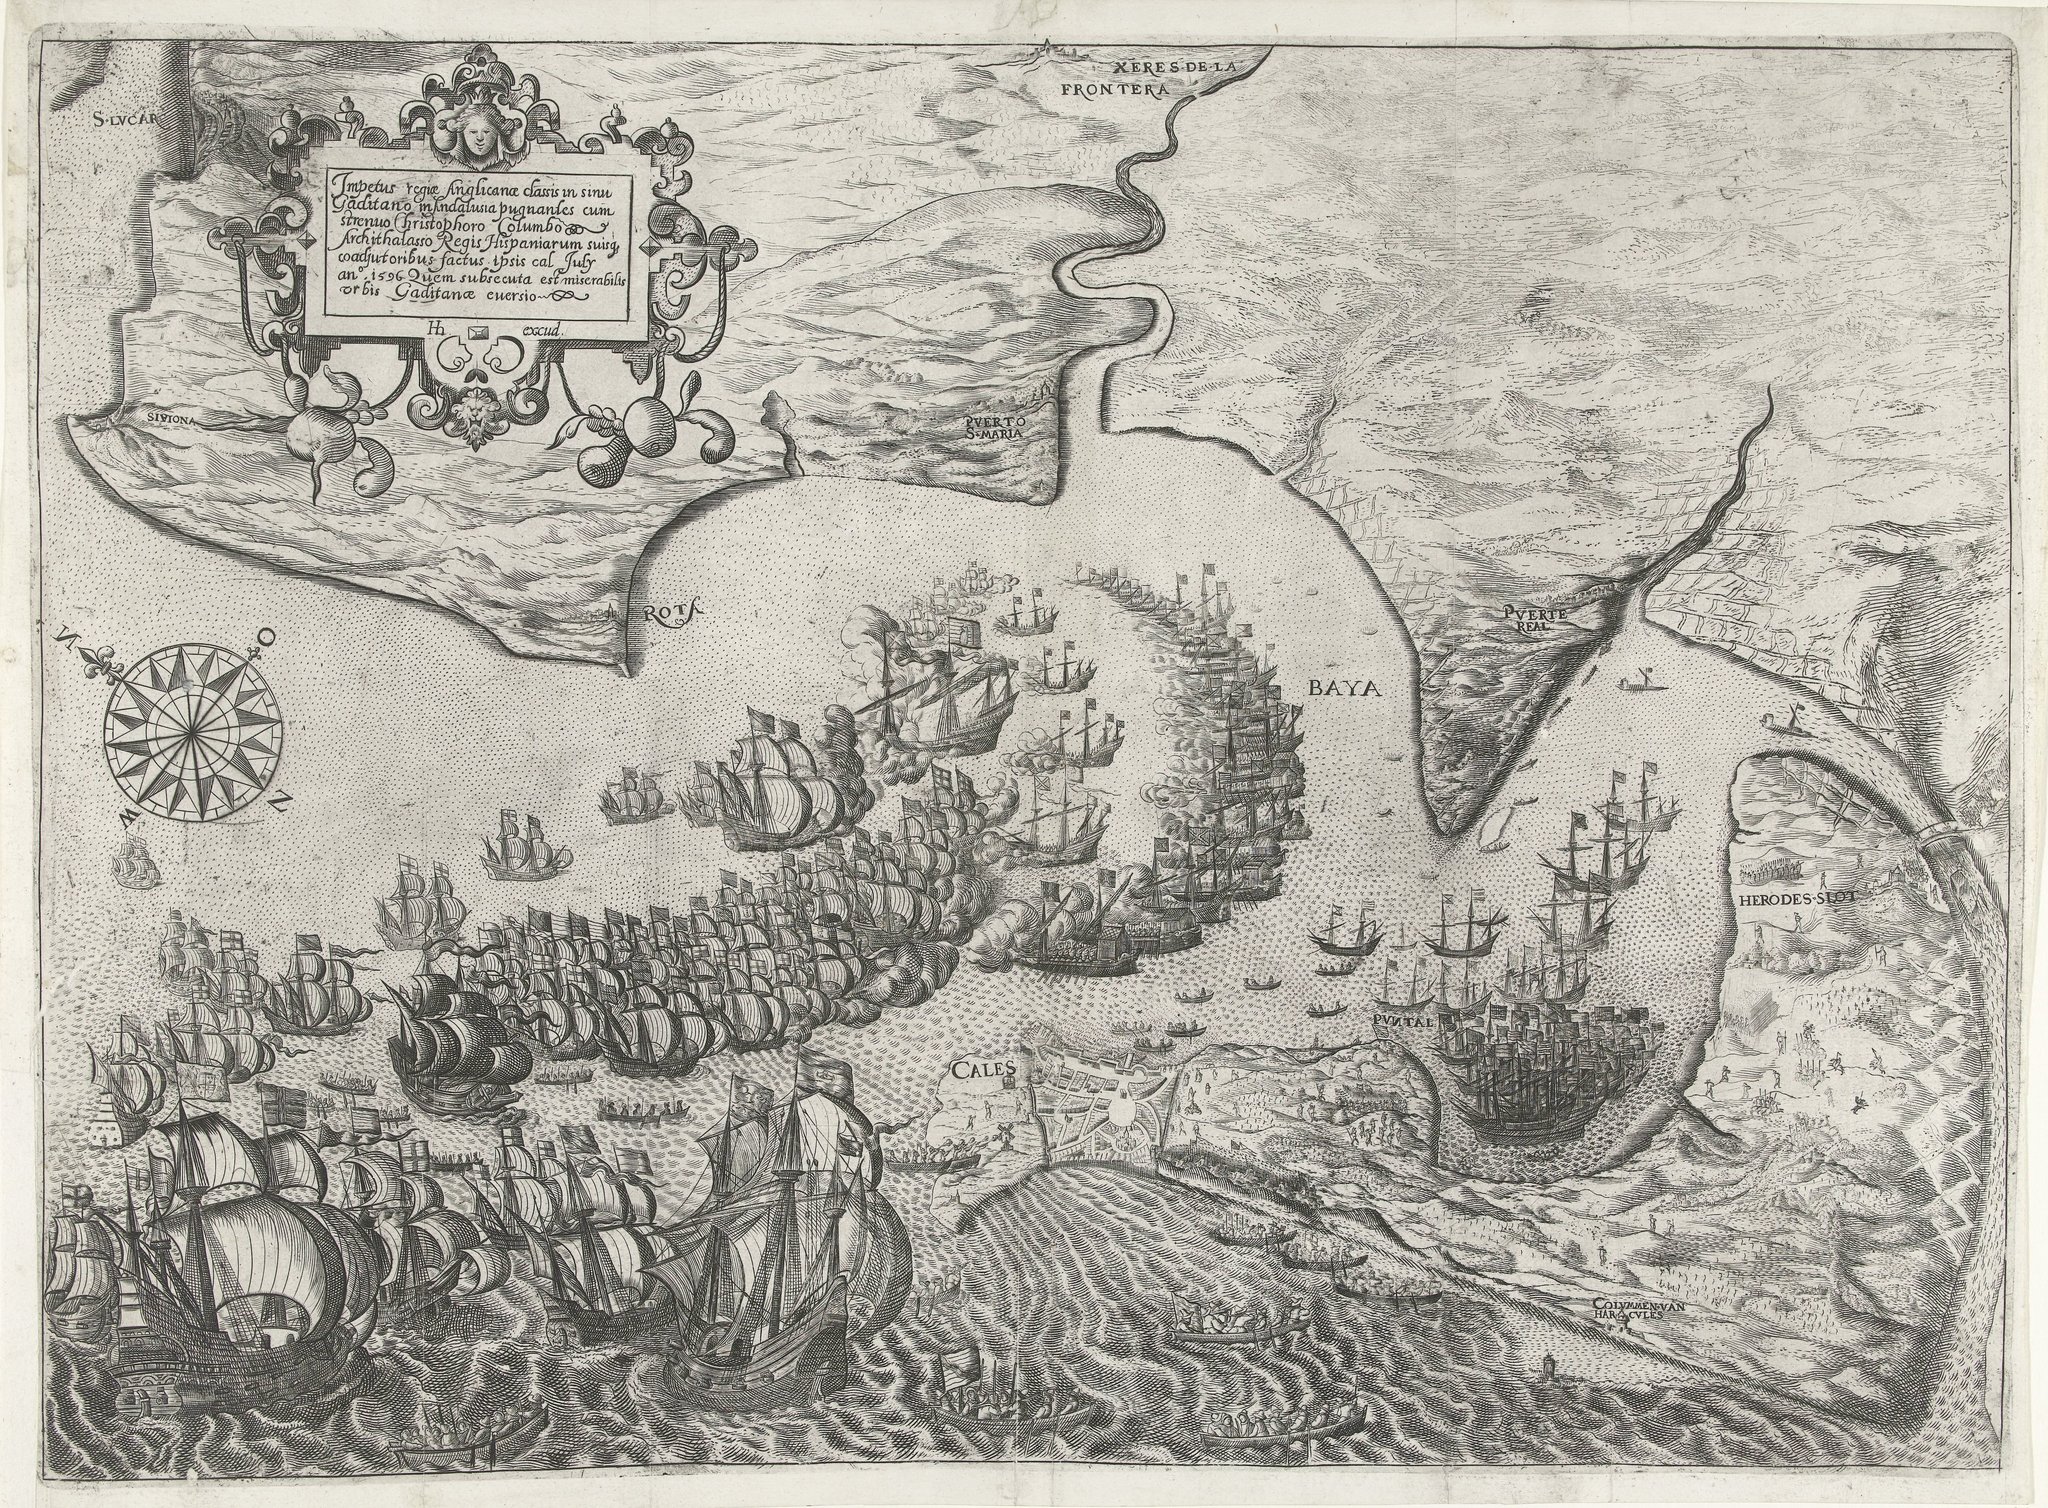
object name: print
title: Zeeslag voor Cadiz, 1596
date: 1596-1598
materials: paper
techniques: engraving, etching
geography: low countries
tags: maps of separate countries or regions, battle (+ naval force)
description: Nederlaag van de Spaanse vloot toegebracht door de Engelse en Nederlandse vloten bij Cadiz, 1 juli 1596. Plan van de baai met midden onder de stad Cadiz gelegen op het Spaanse schiereiland. Linksboven een cartouche met opschrift in het Latijn.